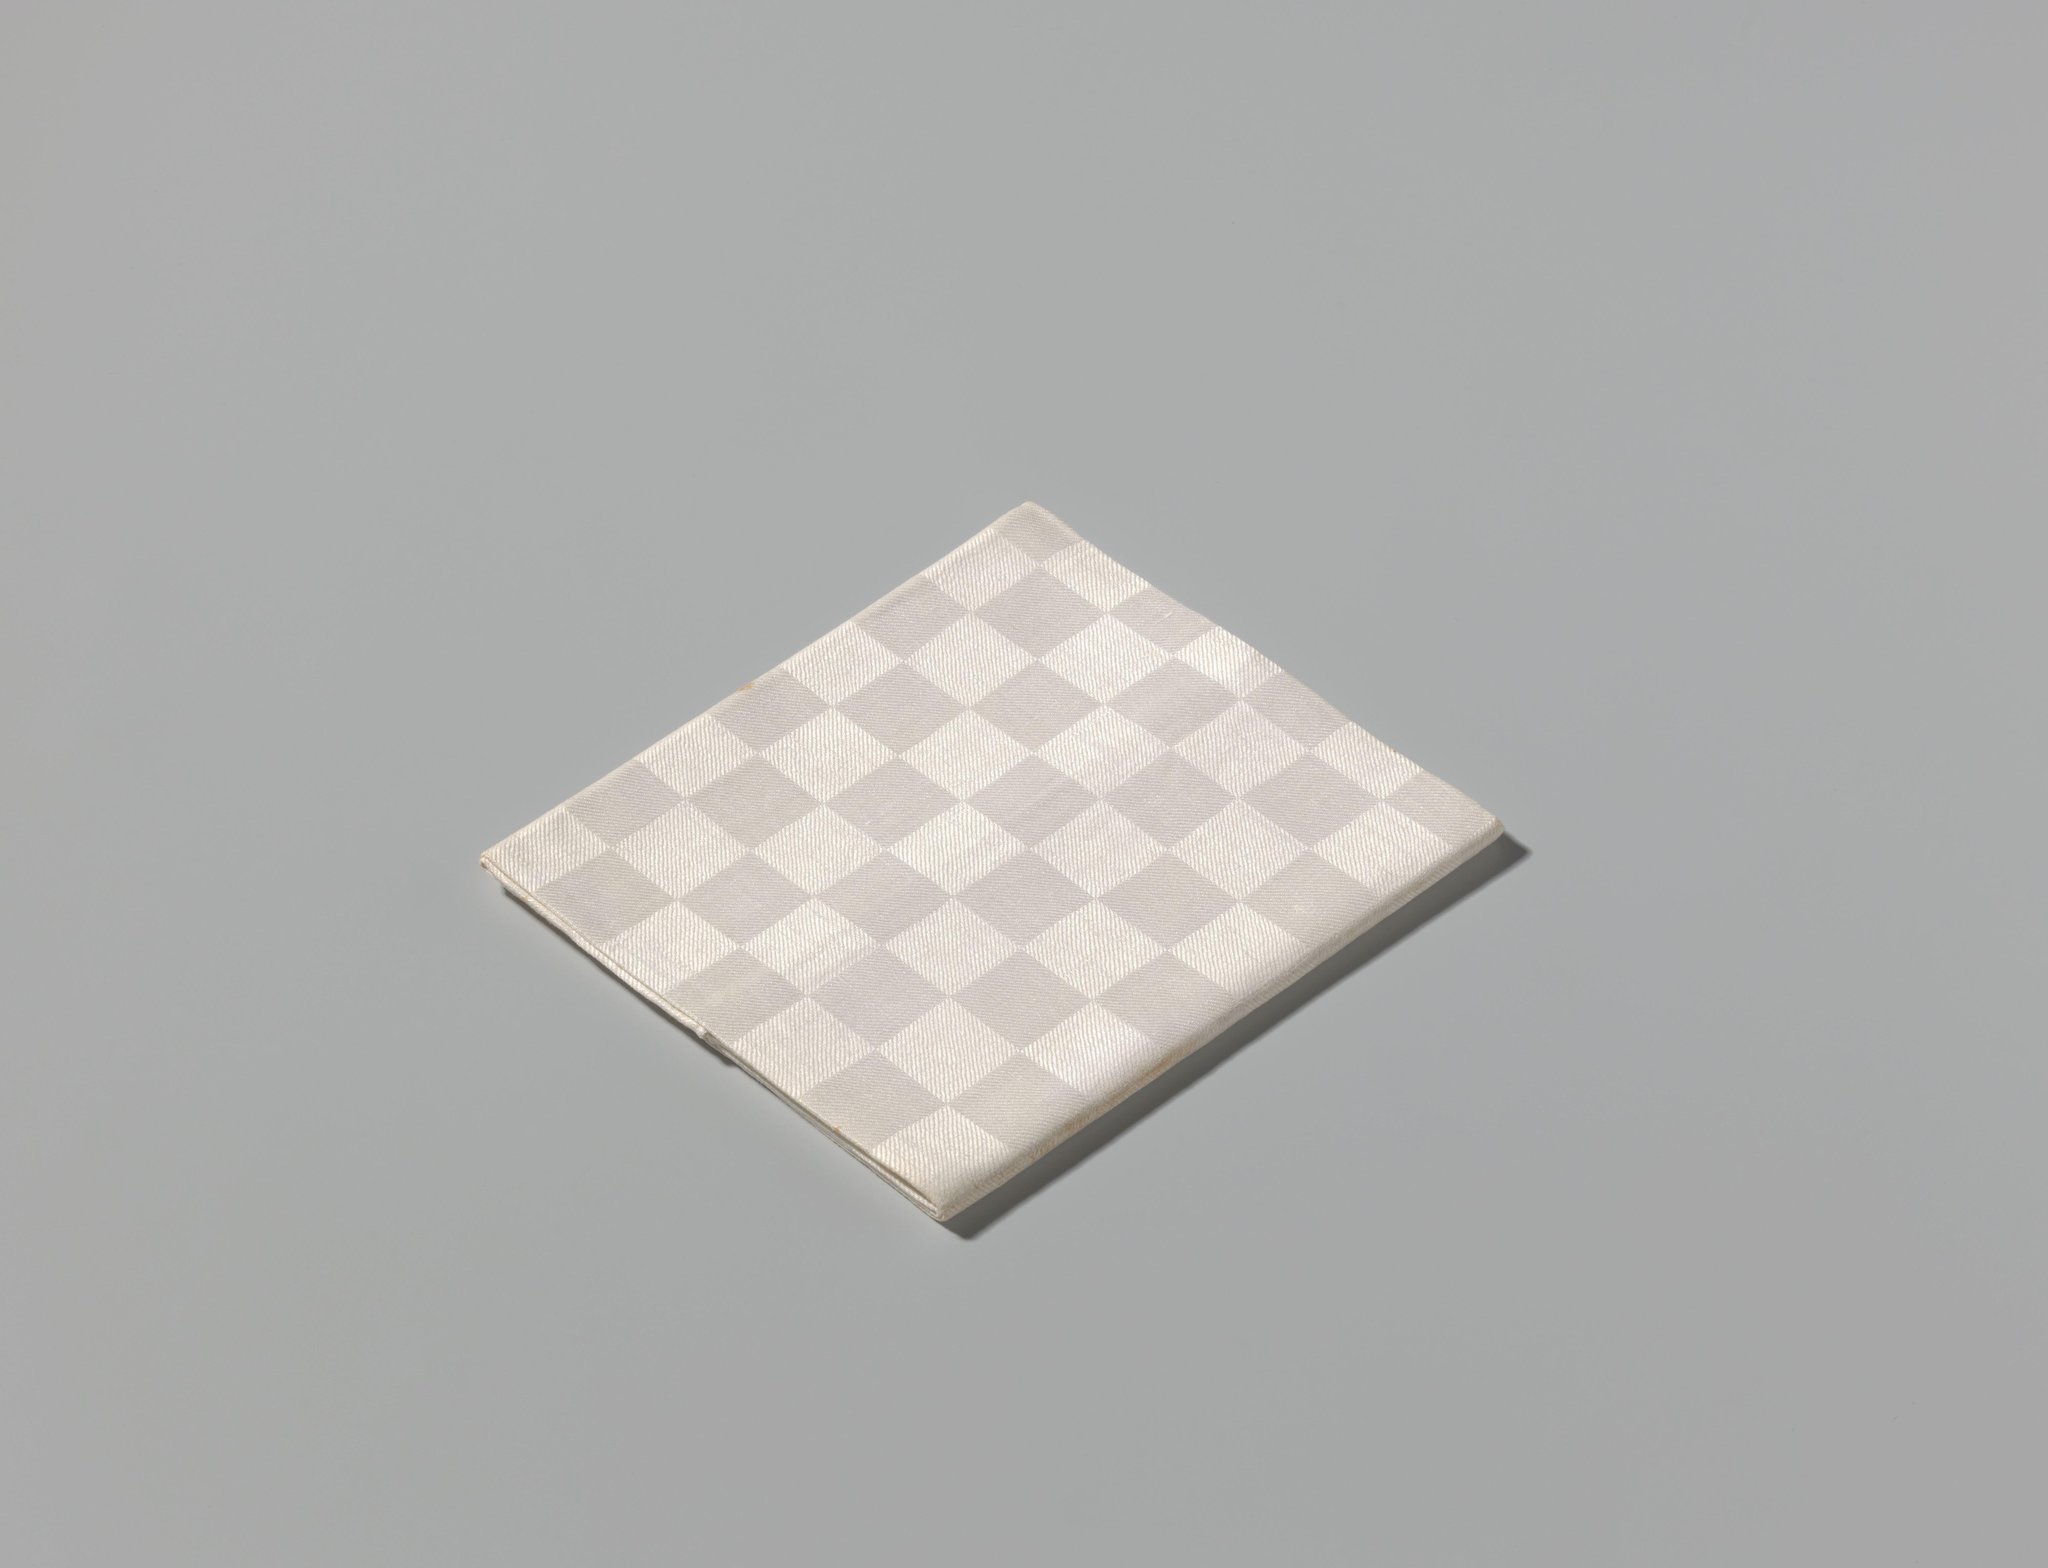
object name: towel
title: Handdoek van wit linnen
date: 1700-1799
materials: linen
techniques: peeled fabric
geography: netherlands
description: Wit linnen handdoek met een pellen blokpatroon, merk WT 74 WH 2oonl.